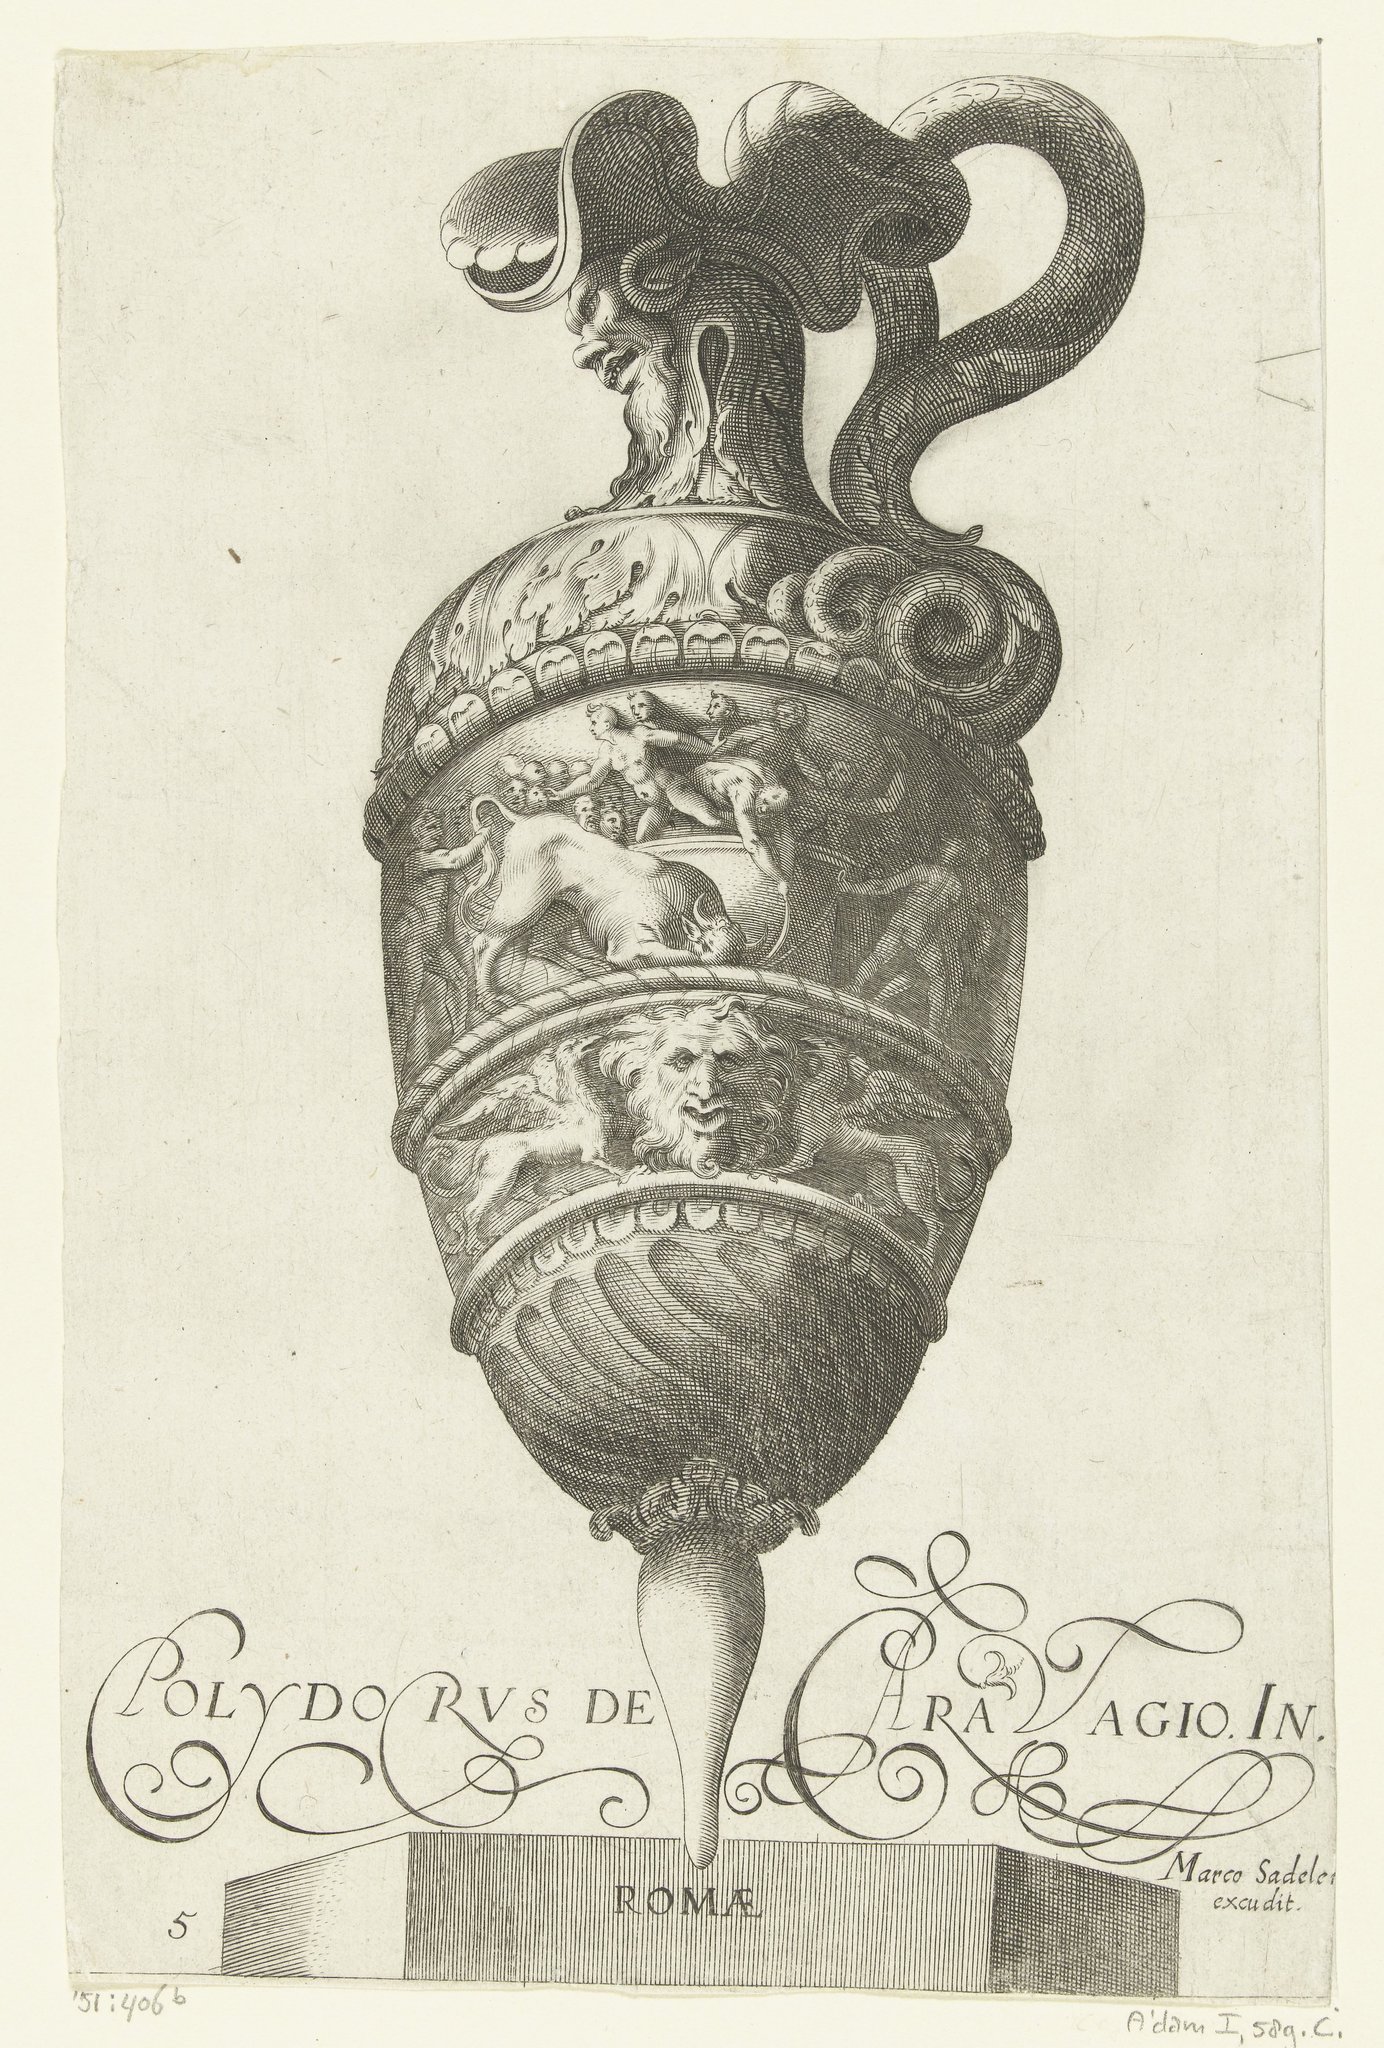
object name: ornament print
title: Kan met een oor waarvan de tuit op een mascaron steunt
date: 1580-1629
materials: paper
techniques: engraving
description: De buik van de vaas is gedecoreerd met een fries waarop mensen een door zijn voorpoten gezakte stier gaan offeren (?). Blad uit de tweede editie van deze serie.